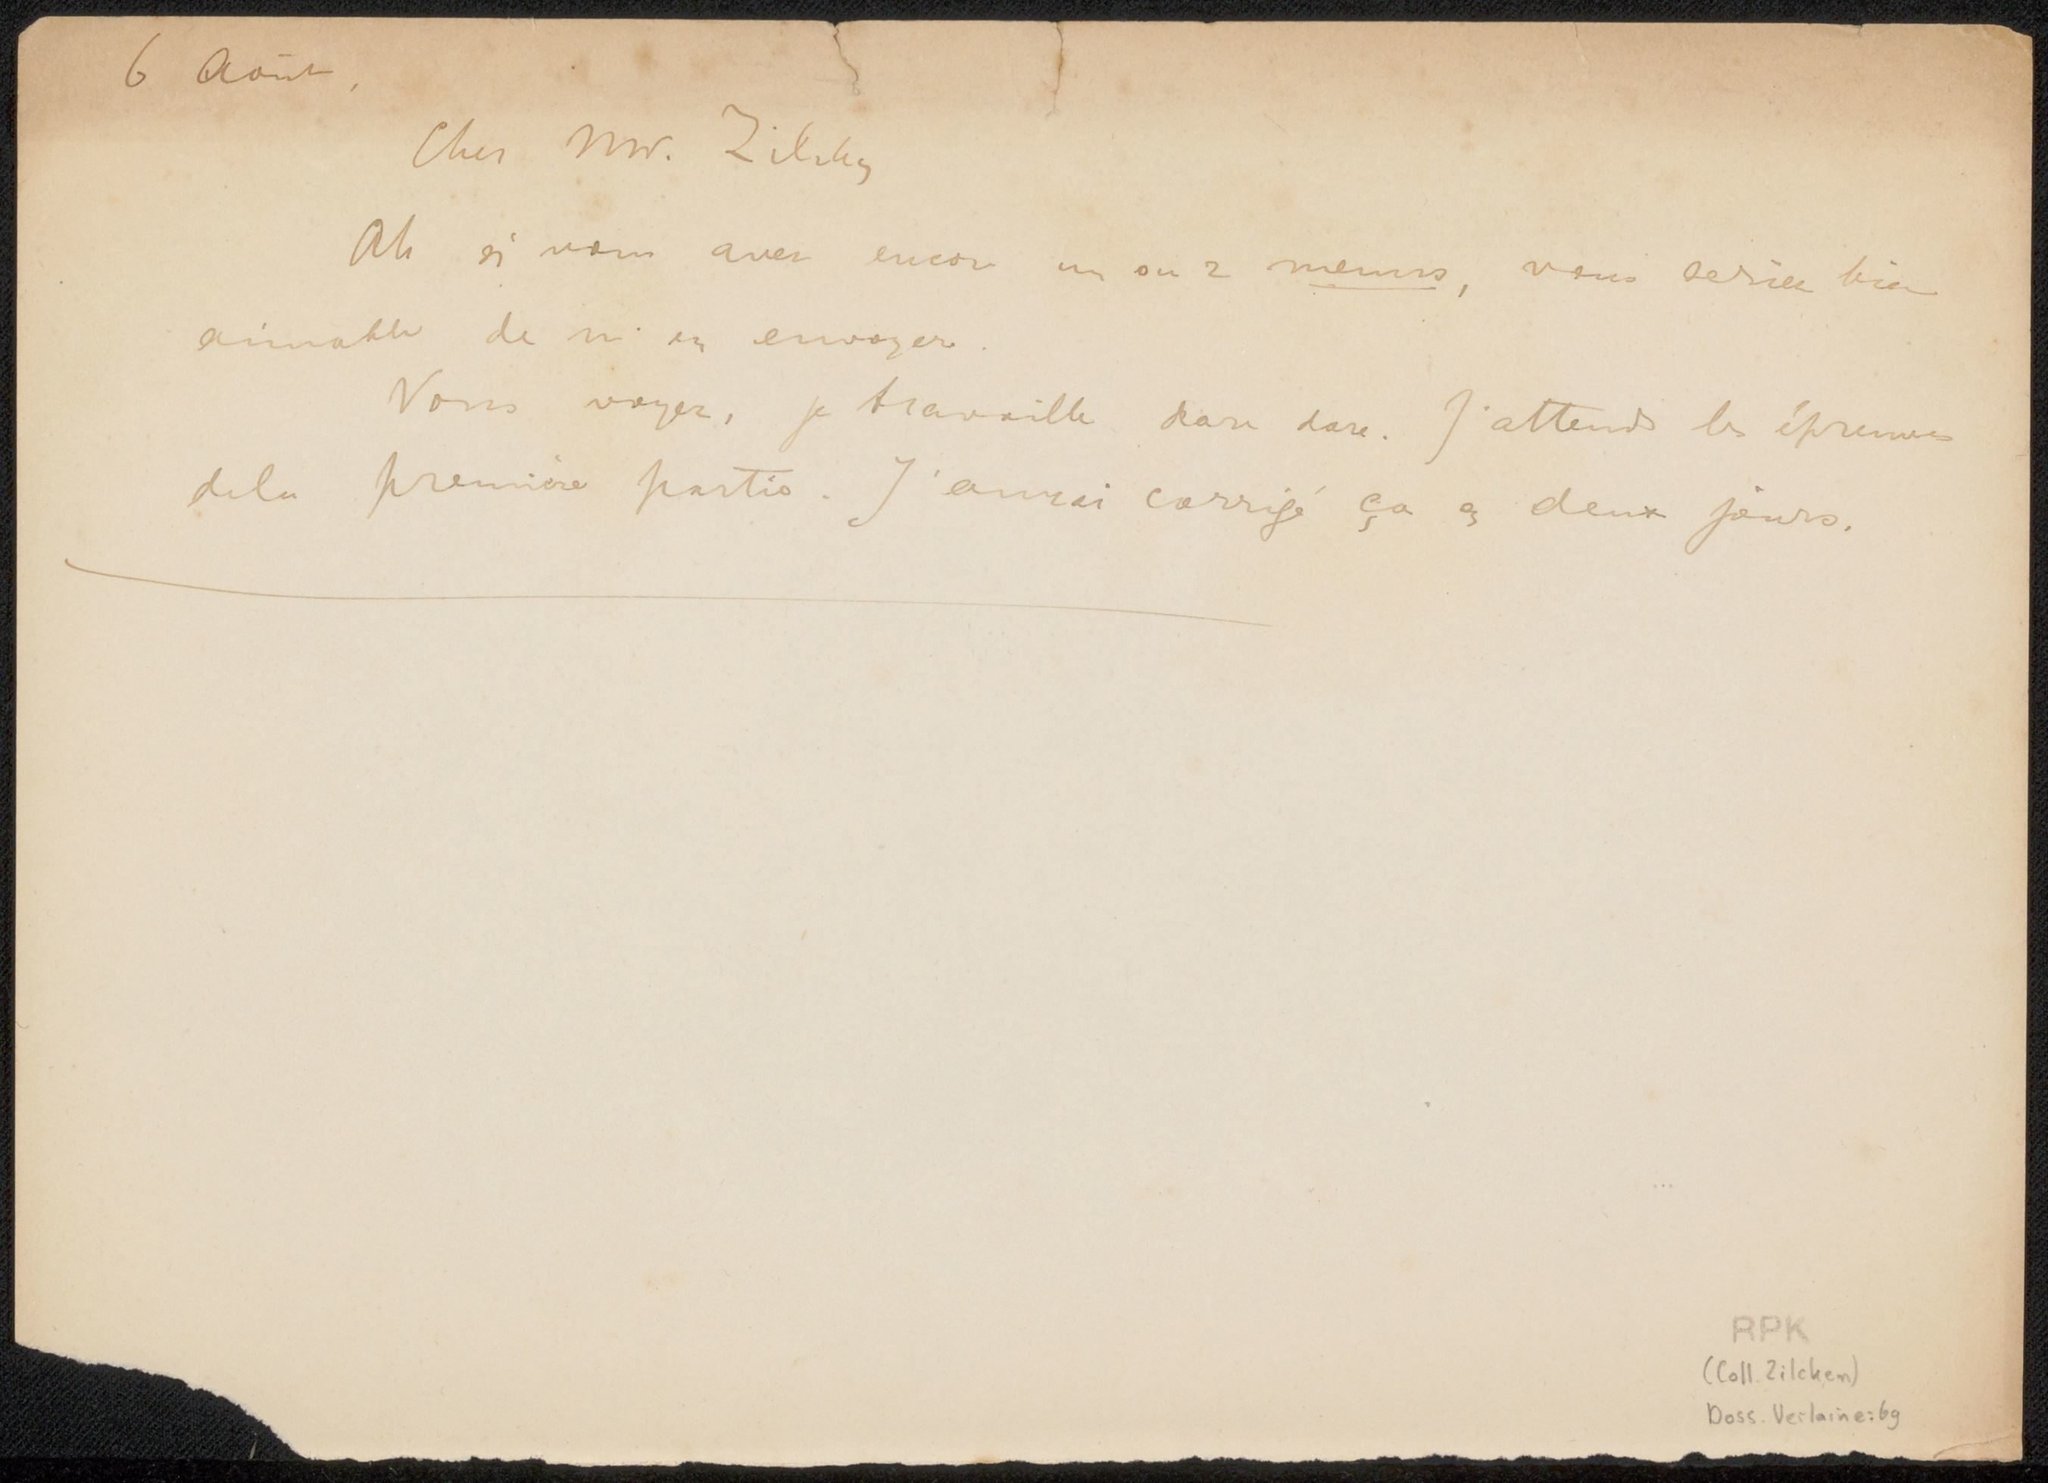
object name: letter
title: Brief aan Philip Zilcken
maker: paul verlaine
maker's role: dichter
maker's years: 1844-1896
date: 1892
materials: ink, paper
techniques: pen, printing, writing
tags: the hague, painter, draughtsman, philip zilcken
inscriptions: collector's mark: ‘RPK’